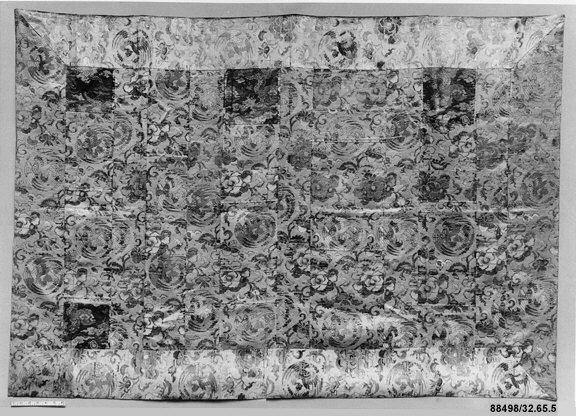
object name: robe, priest's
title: Priest's Robe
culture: japanese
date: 1601-1700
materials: silk